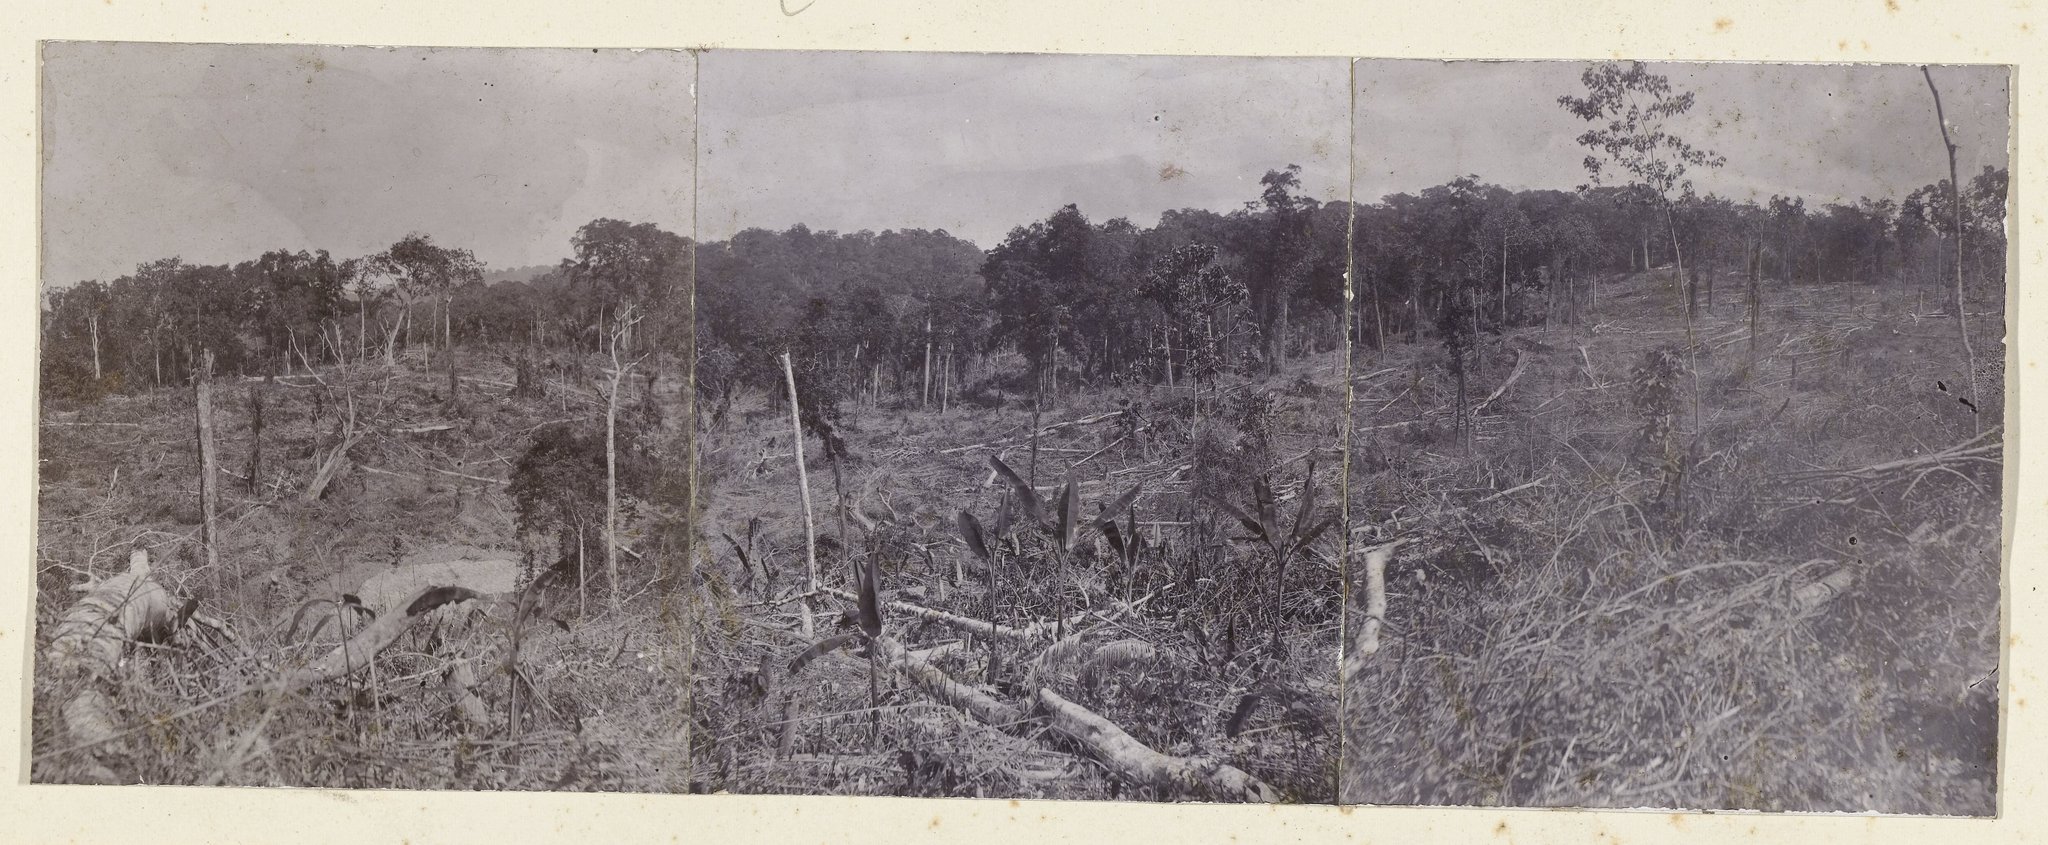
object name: photograph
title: Panoramalandschap met veel houtkap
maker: Anonymous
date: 1890-1910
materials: cardboard, paper, photographic support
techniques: gelatin silver print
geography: indonesia